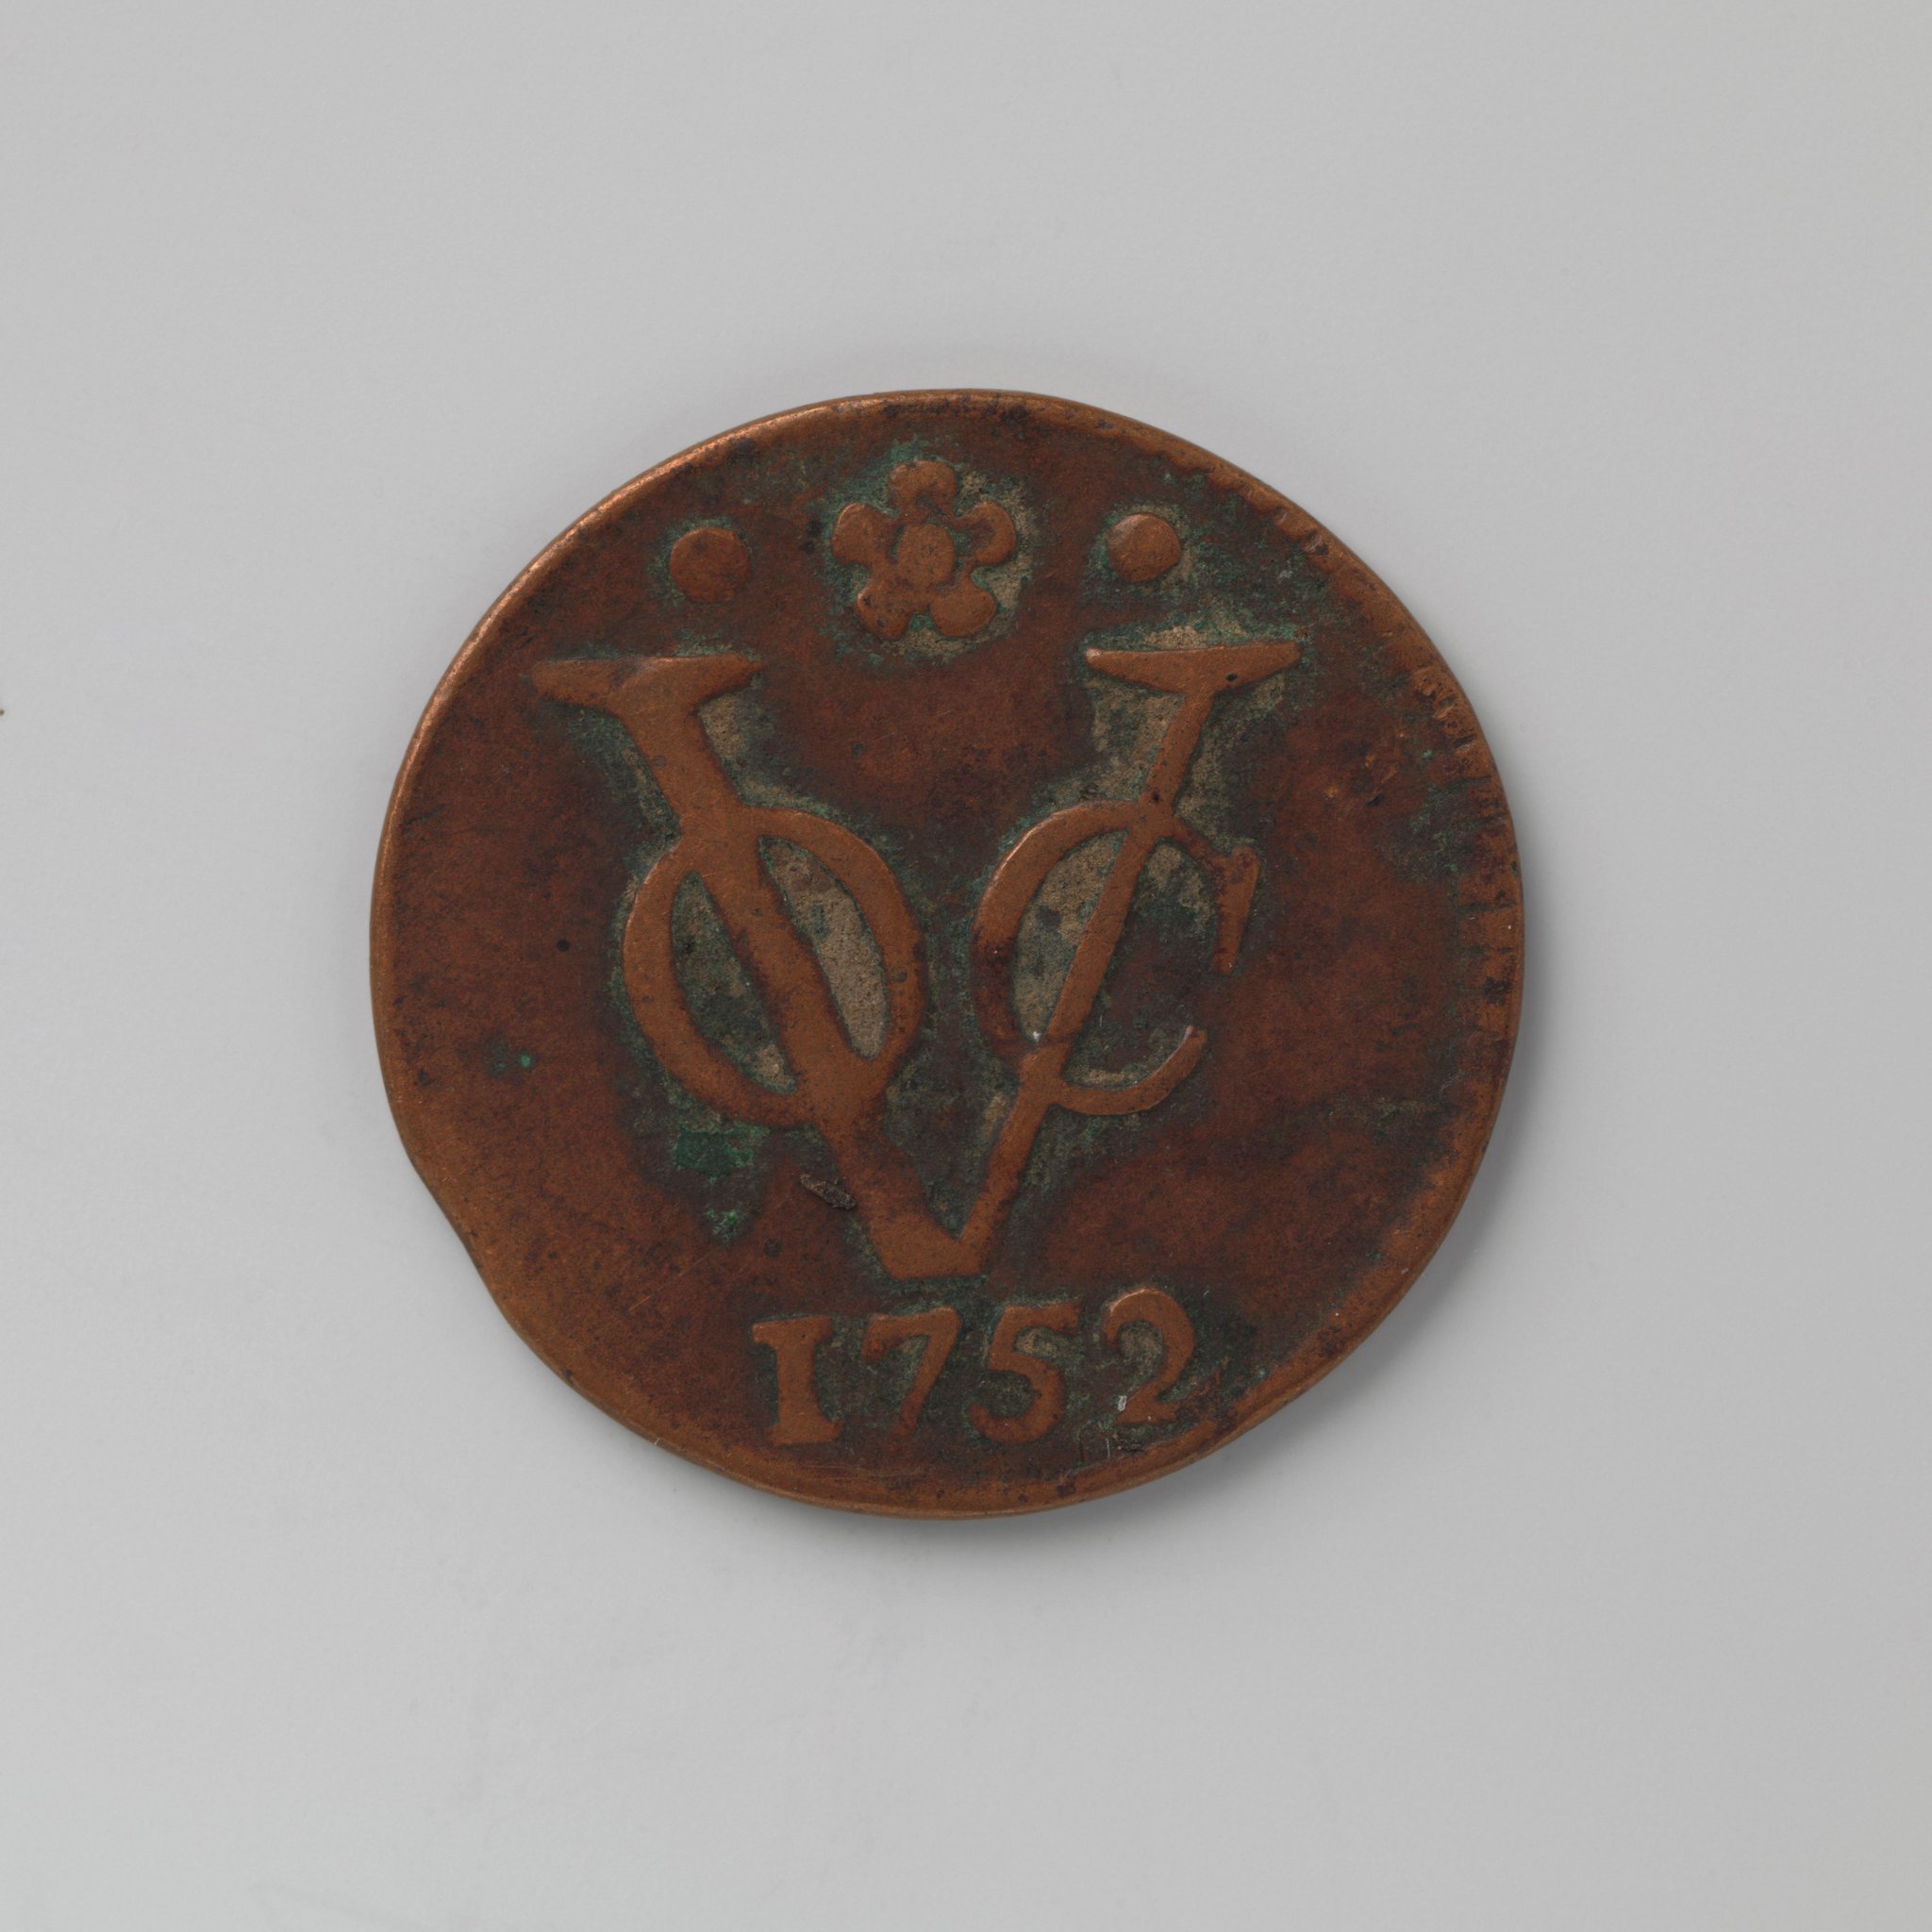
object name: coin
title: VOC, duit Holland, 1752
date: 1752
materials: copper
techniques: striking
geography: dordrecht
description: Koperen munt. Voorzijde: gekroond wapenschild van Holland. Keerzijde: monogram van de VOC, waarboven muntteken en waaronder jaartal. Gladde rand.